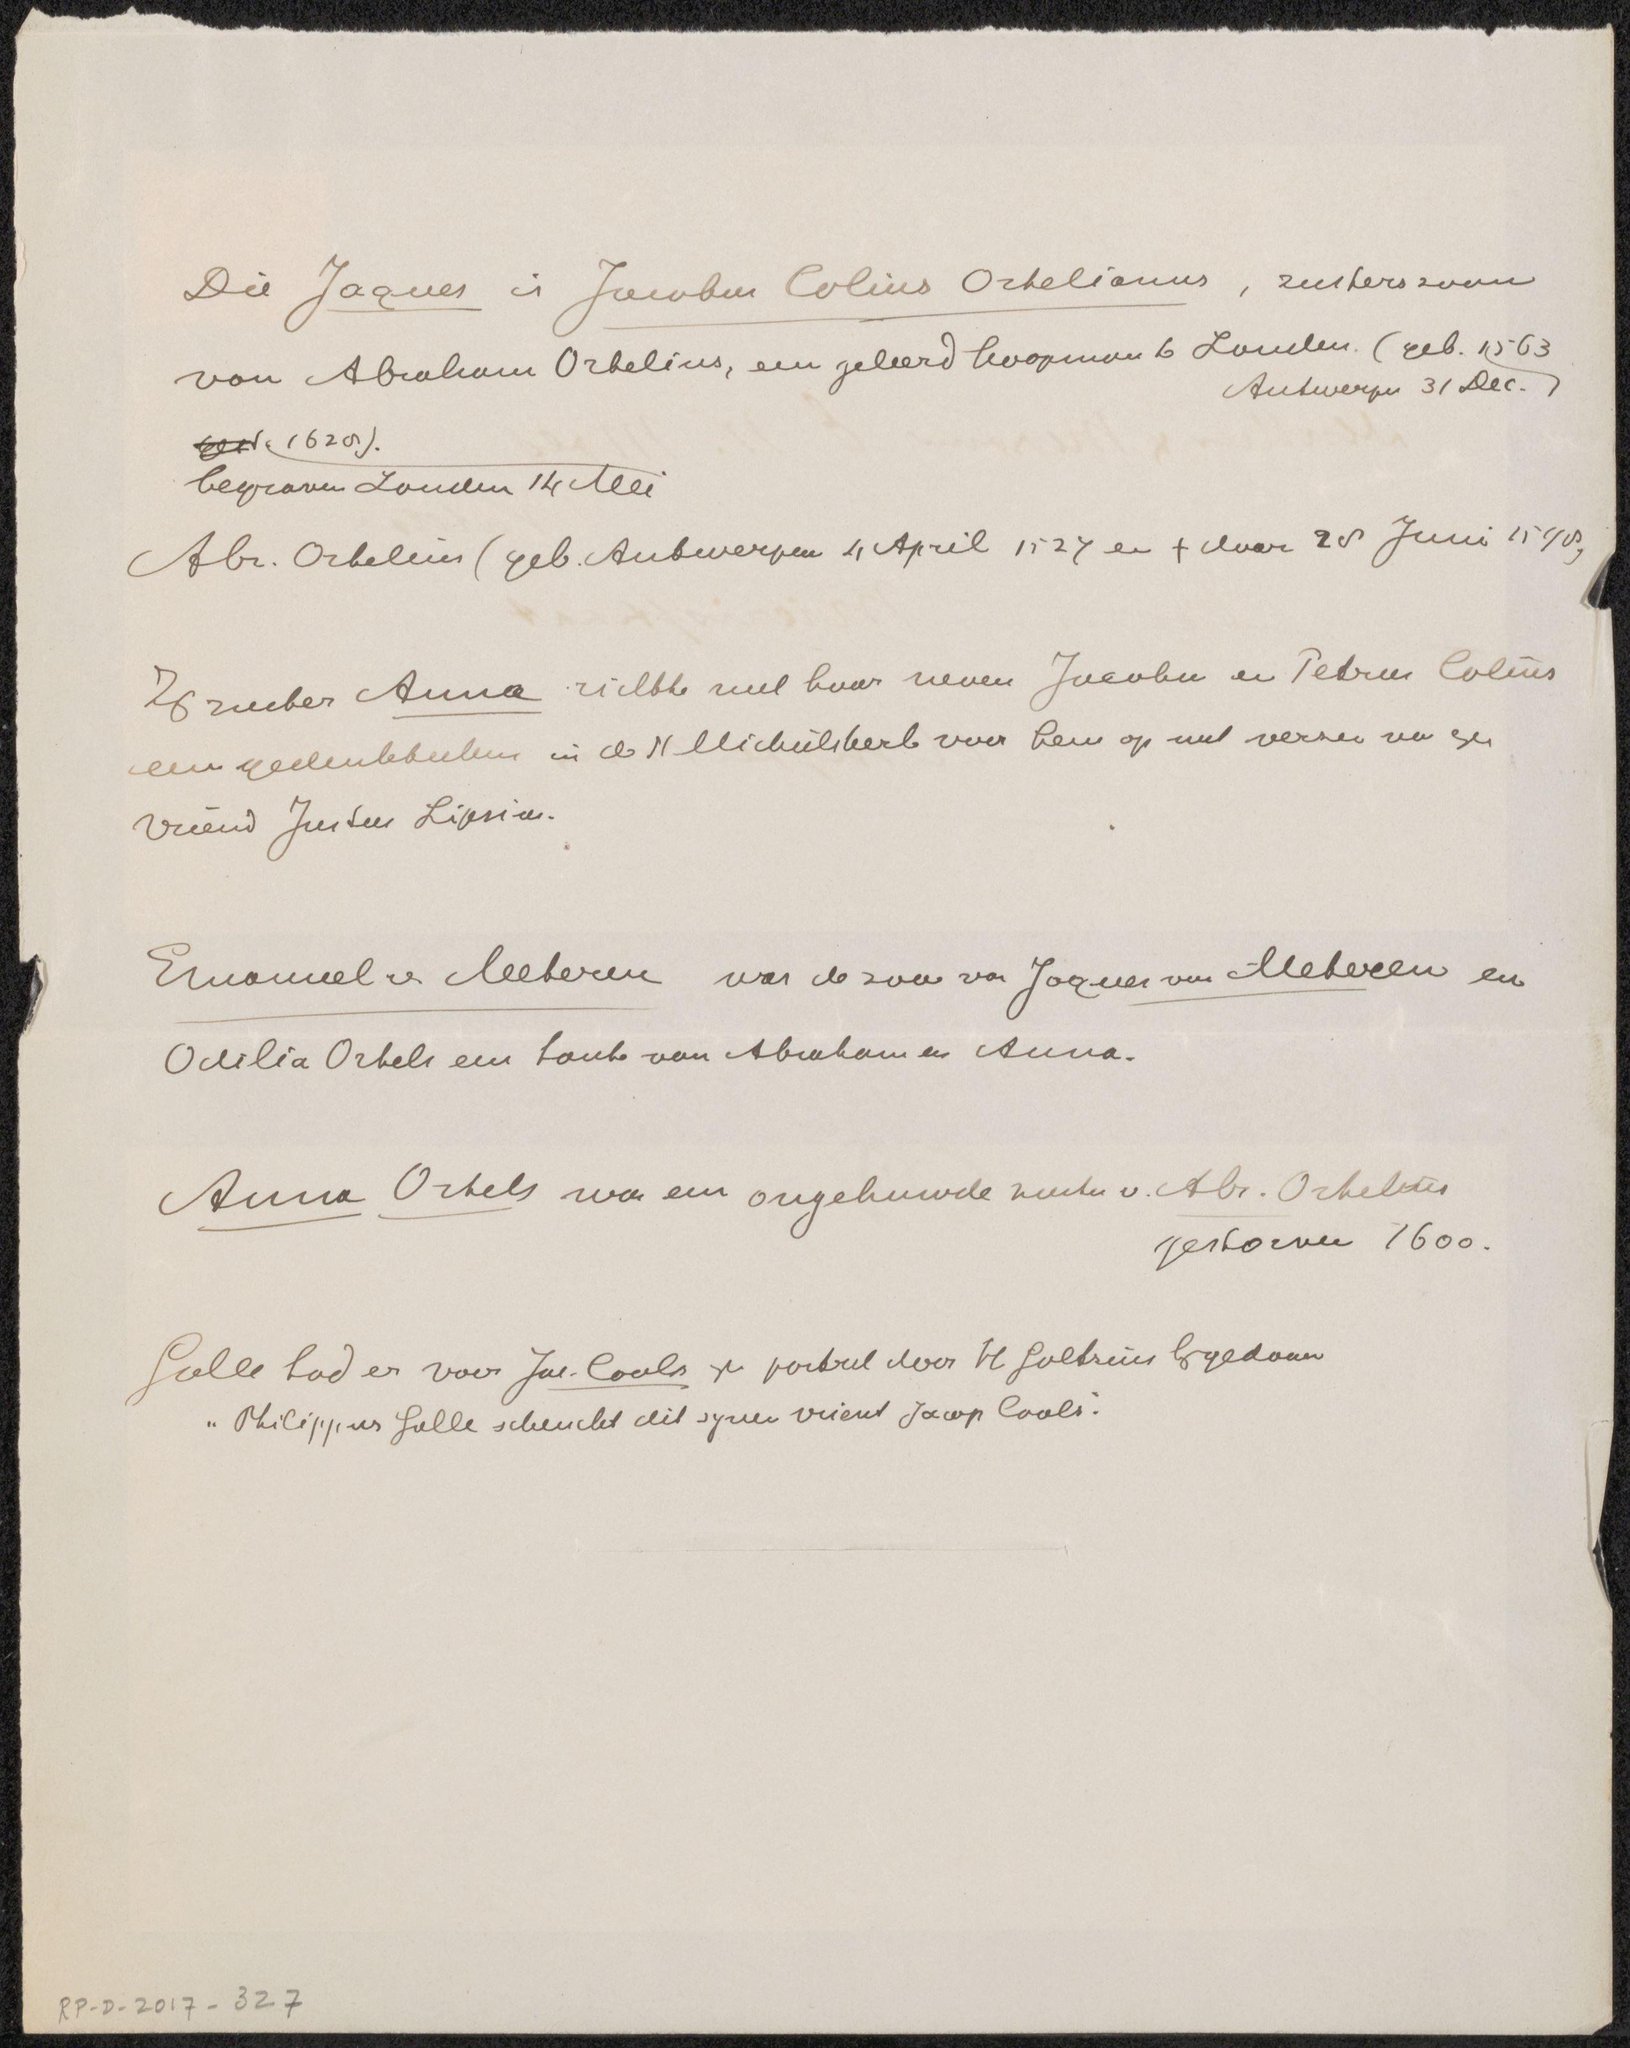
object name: envelope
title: Envelop aan Ernst Wilhelm Moes en Cornelia Rembrandina Valeton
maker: Anonymous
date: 1896-1912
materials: ink, paper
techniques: pen, writing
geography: the hague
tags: haarlem, painter, print maker, draughtsman, hendrick goltzius, publisher, philips galle, amsterdam, ernst wilhelm moes